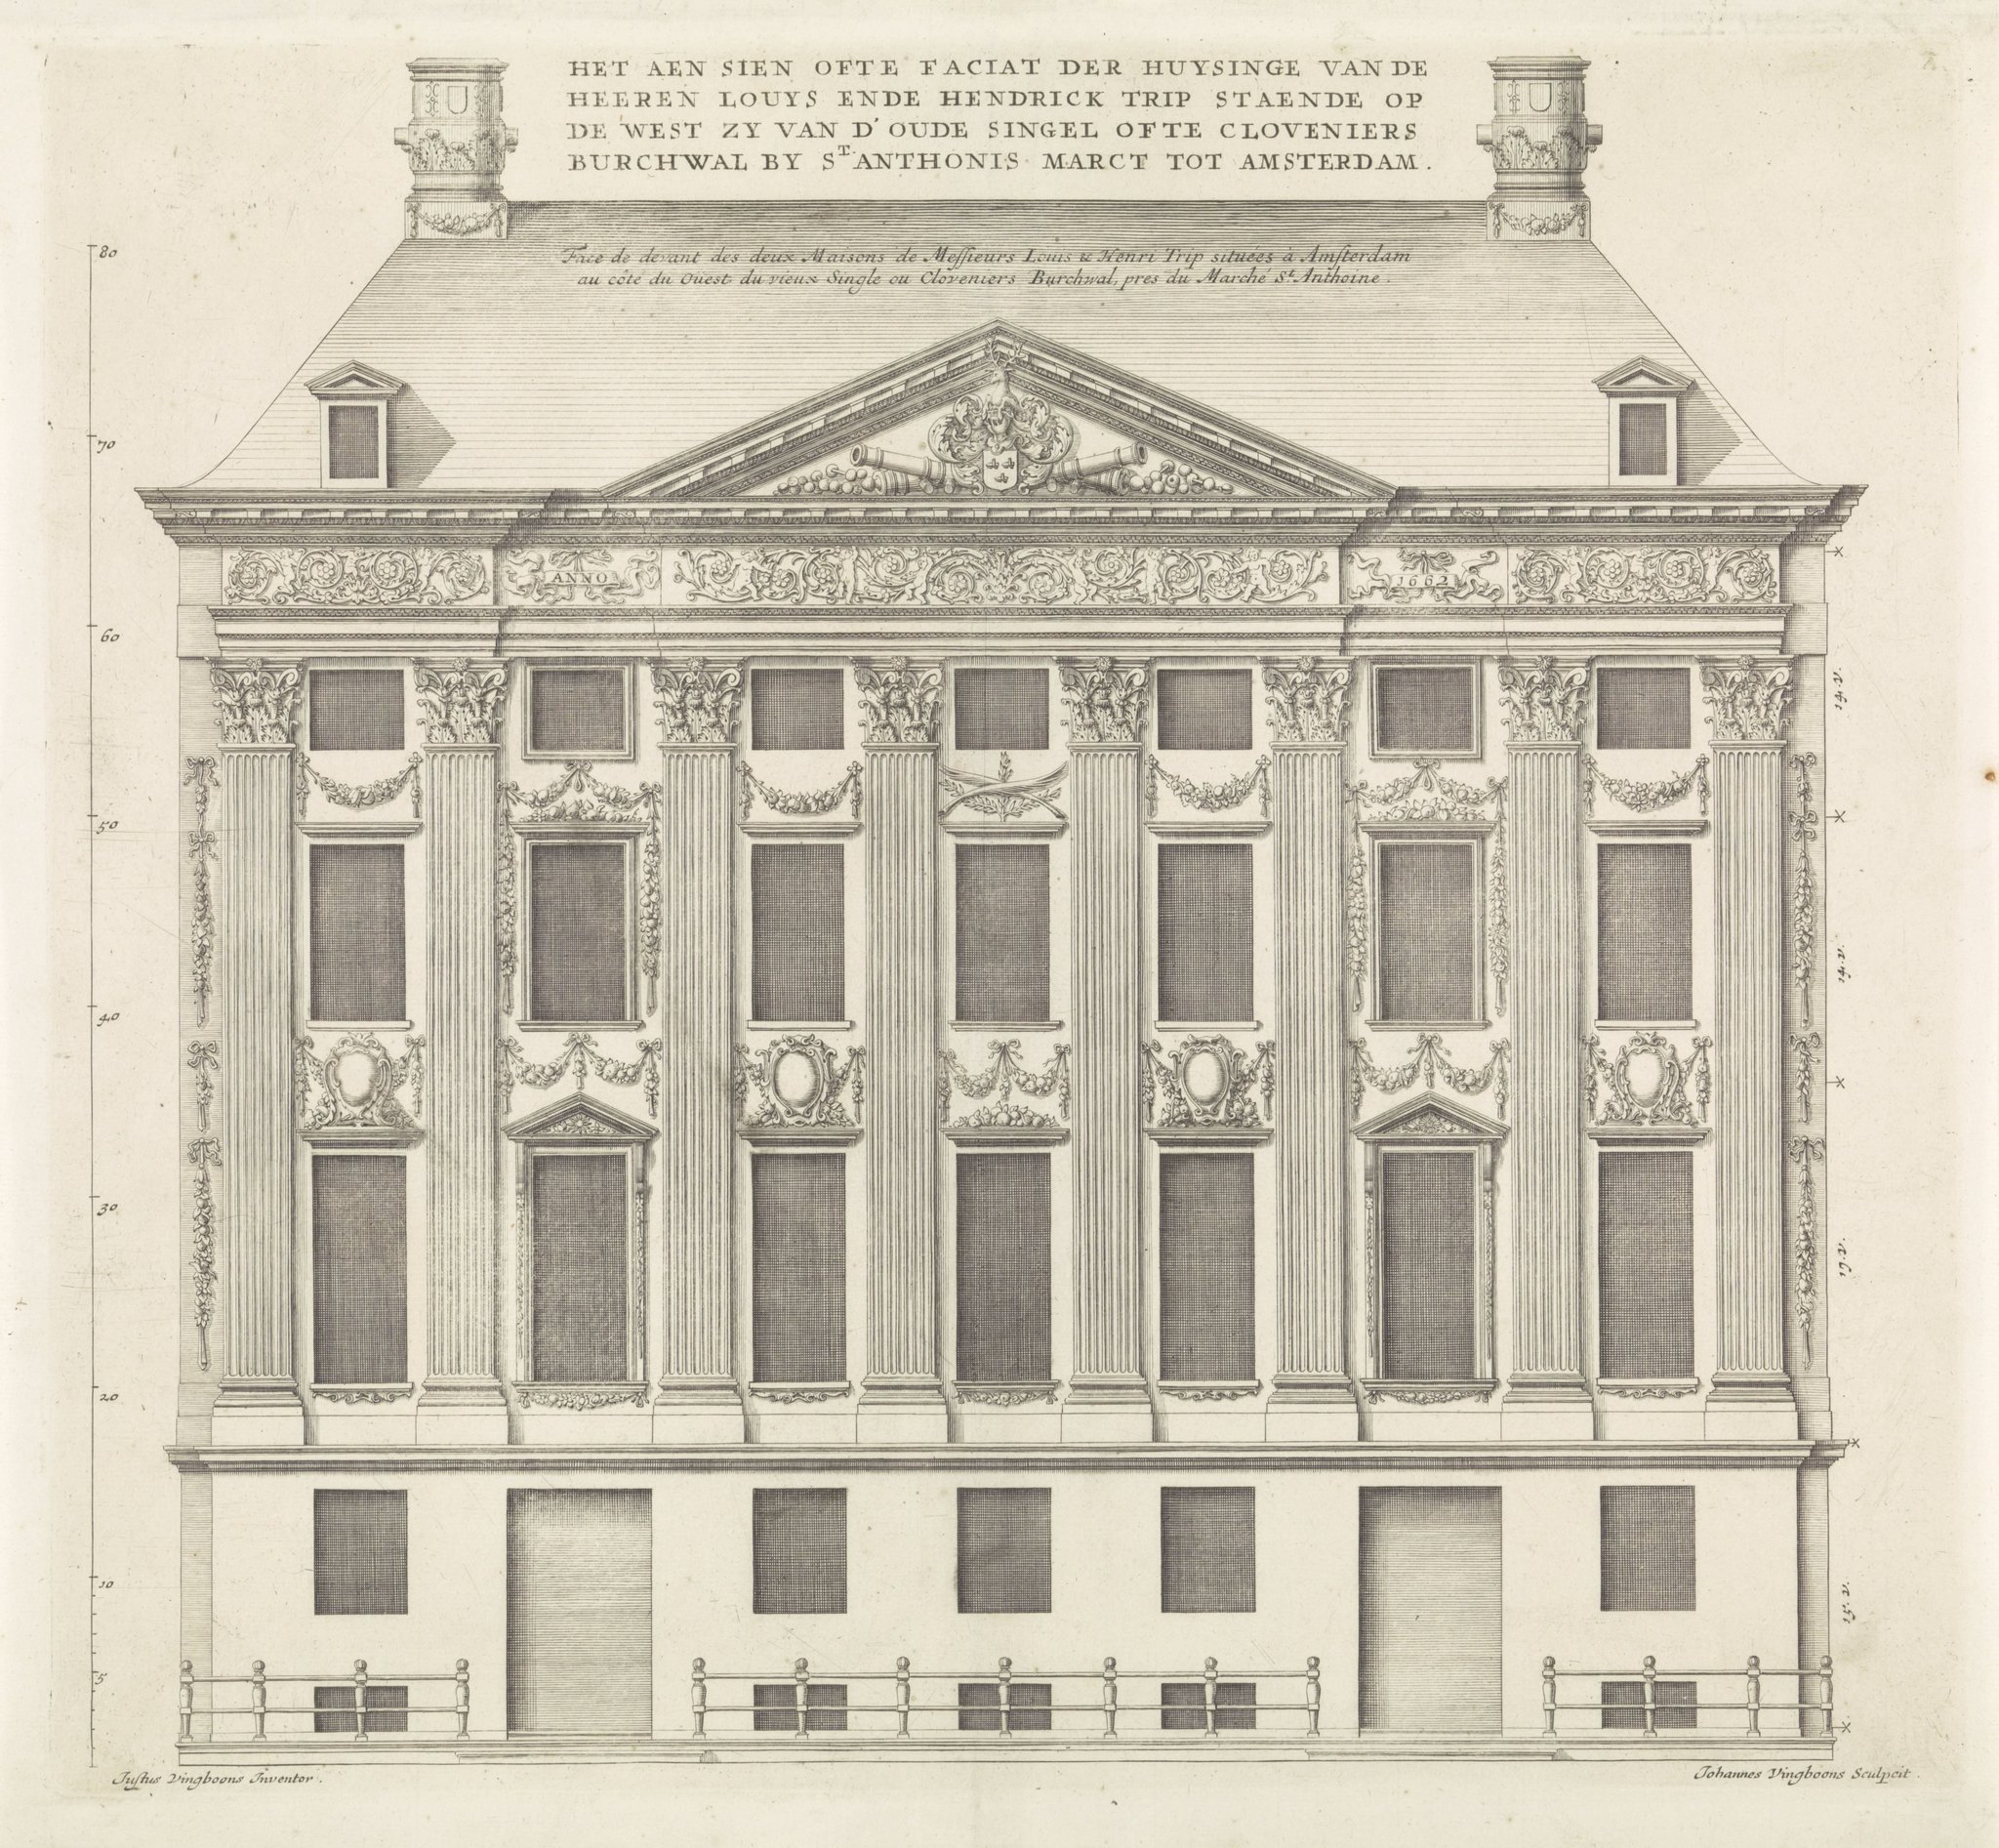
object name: print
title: Het aen sien ofte faciat der huysinge van de heeren louys ende hendrick trip staende op de west zy van d'oude singel ofte cloveniersburchwal by st. anthonis marct tot amsterdam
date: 1664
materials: paper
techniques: engraving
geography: amsterdam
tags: trippenhuis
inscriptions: collector's mark: Lugt 2228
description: Prent gebruikt in: Vingboons, J. Het huys van de heeren Louys en Hendrick Trip. Amsterdam: Justus en Joan Vingboons, verkocht bij Joan Blaeu, 1664.